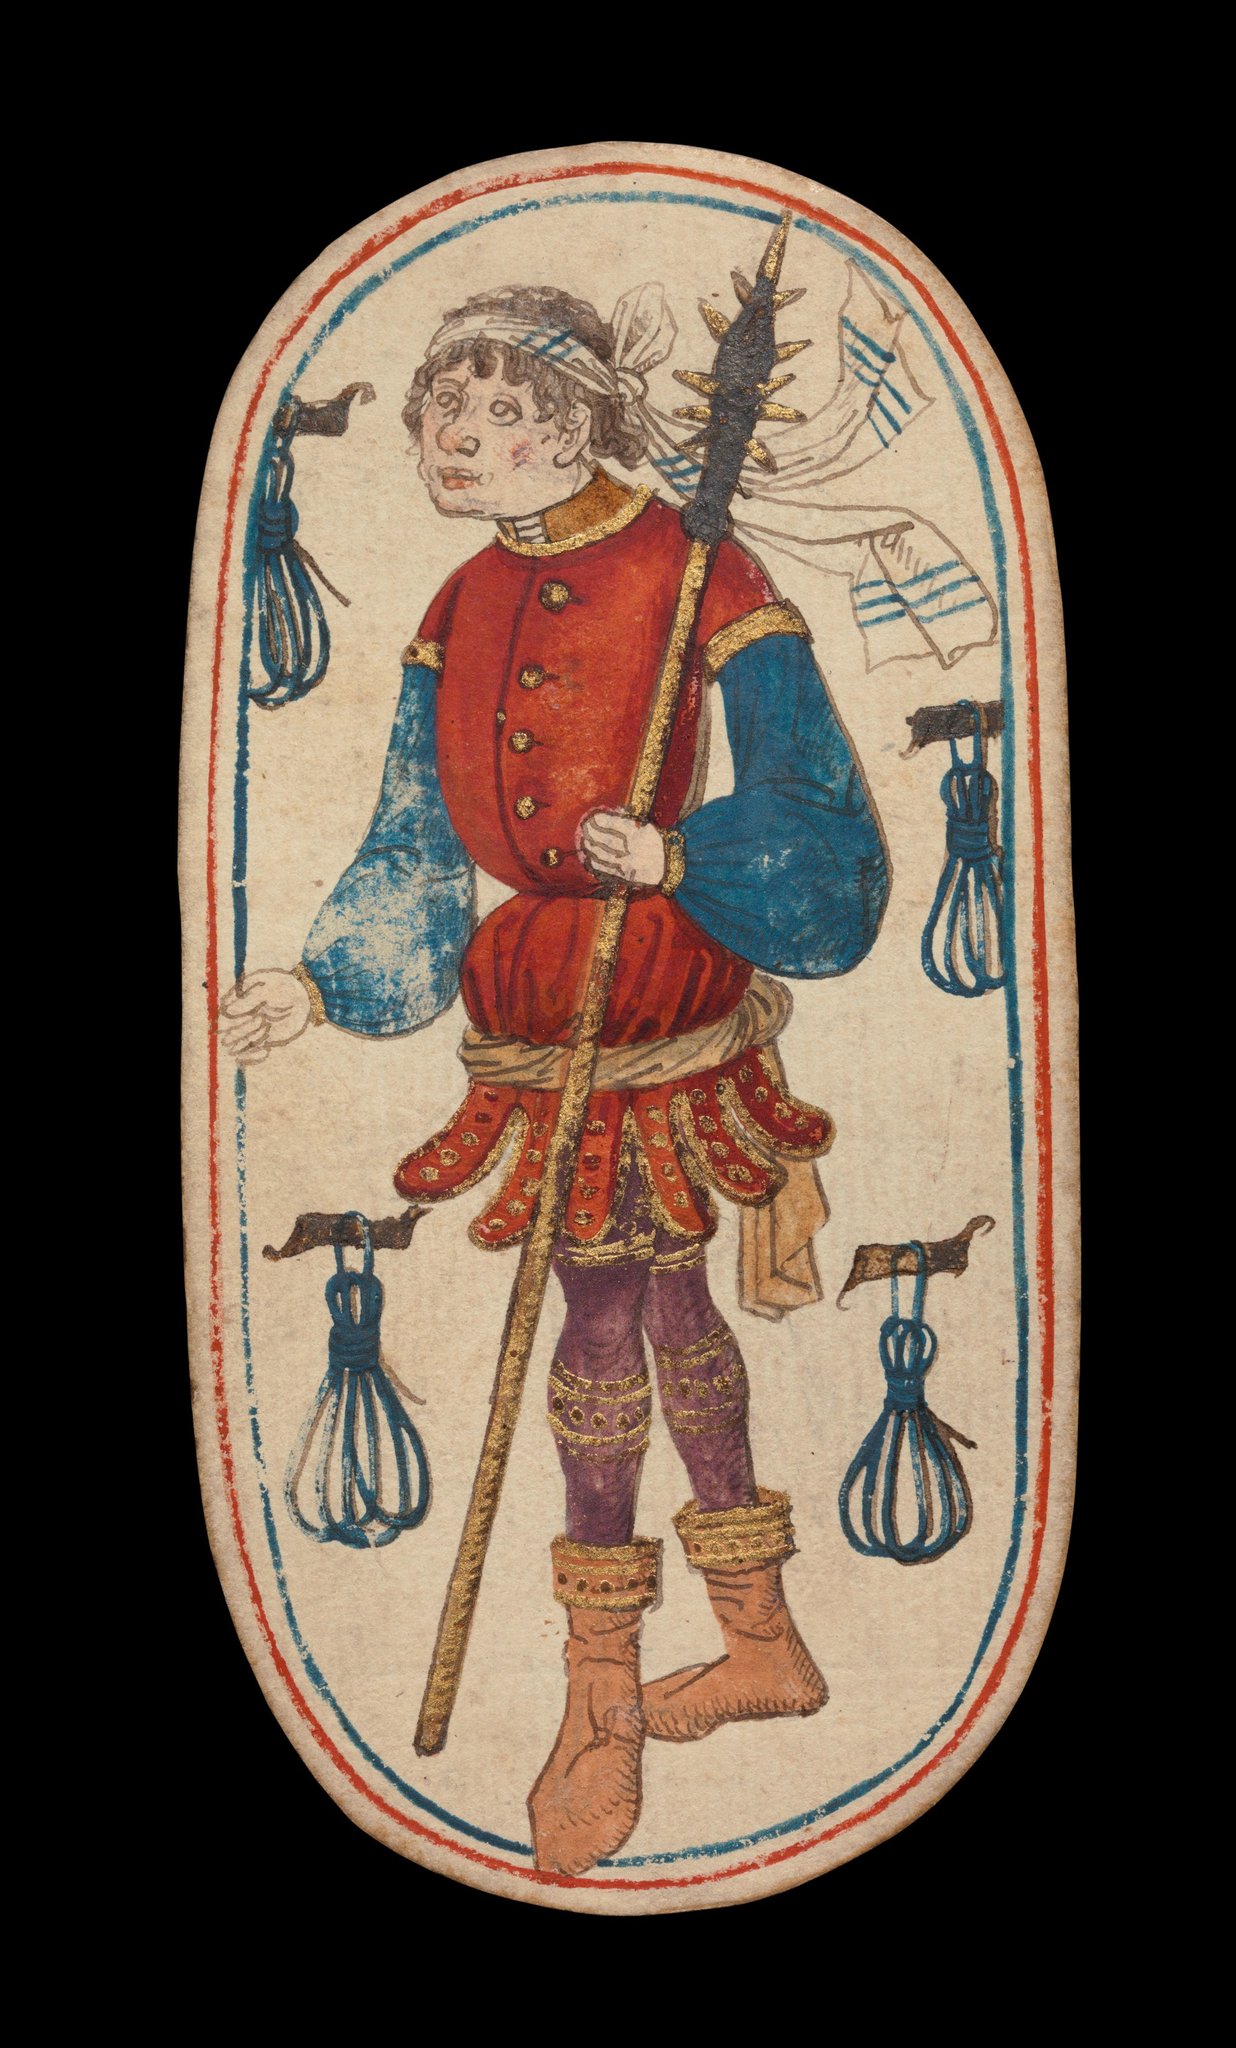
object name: playing card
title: Knave of Tethers, from The Cloisters Playing Cards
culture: south netherlandish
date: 1475-1480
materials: glaze, gold, ink, paint, paper, silver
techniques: pen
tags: men,playing cards,games